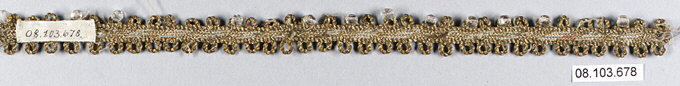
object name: passementerie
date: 1701-1900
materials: metal thread